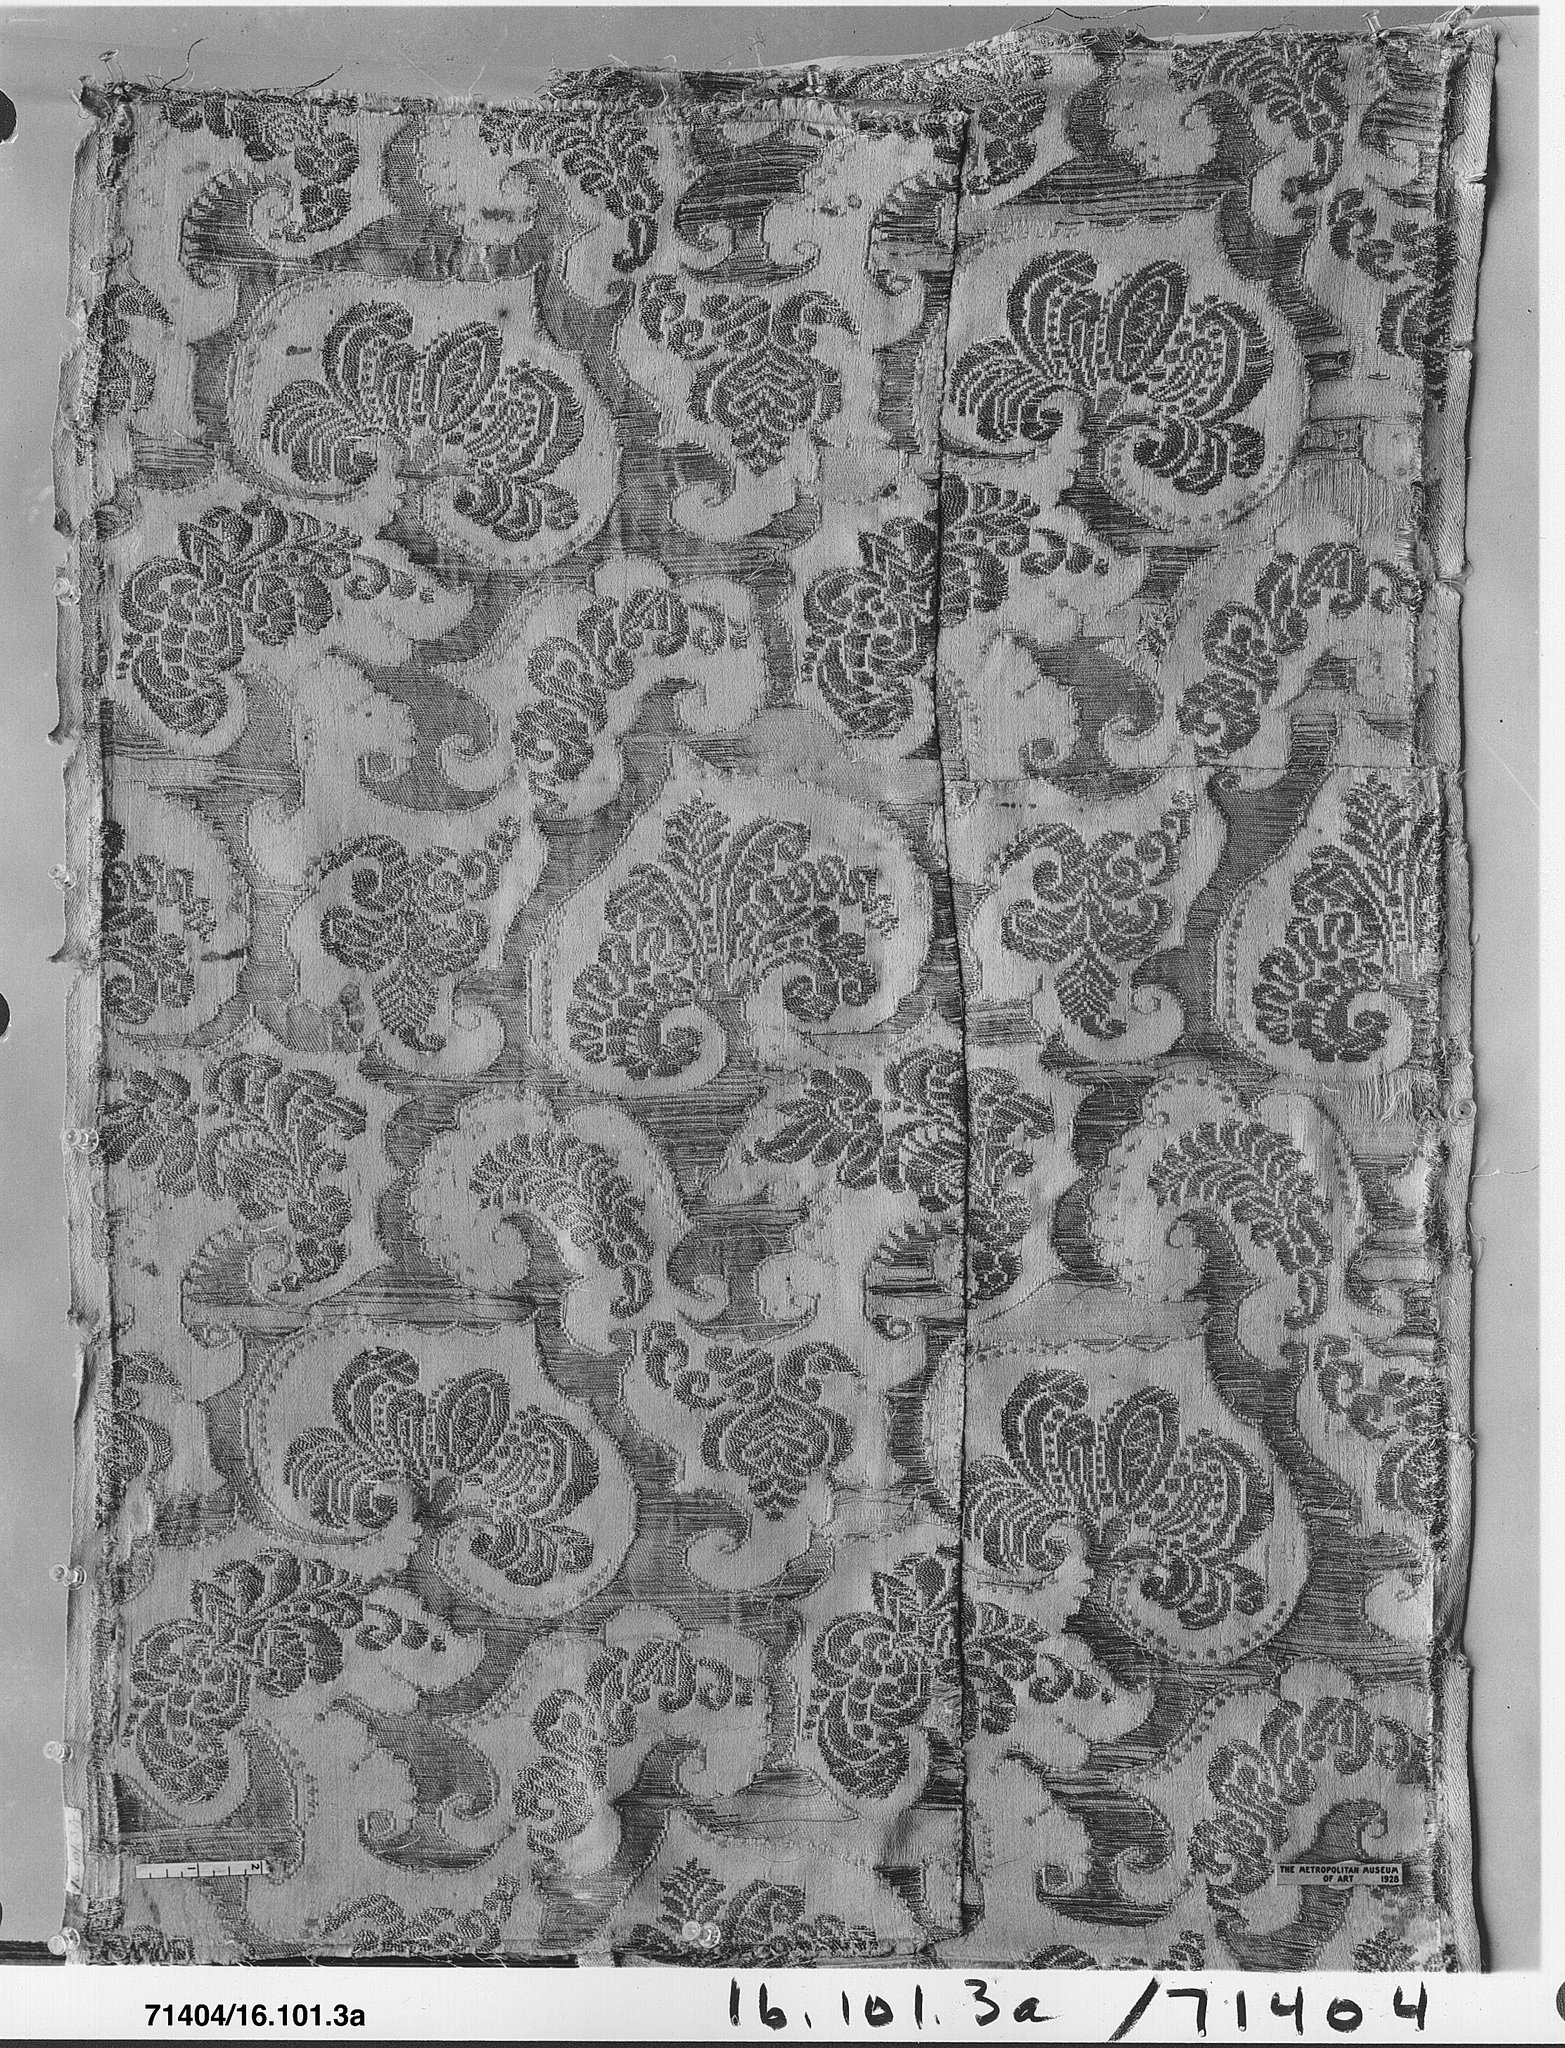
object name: piece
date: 1650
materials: metal thread, silk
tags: flowers,leaves